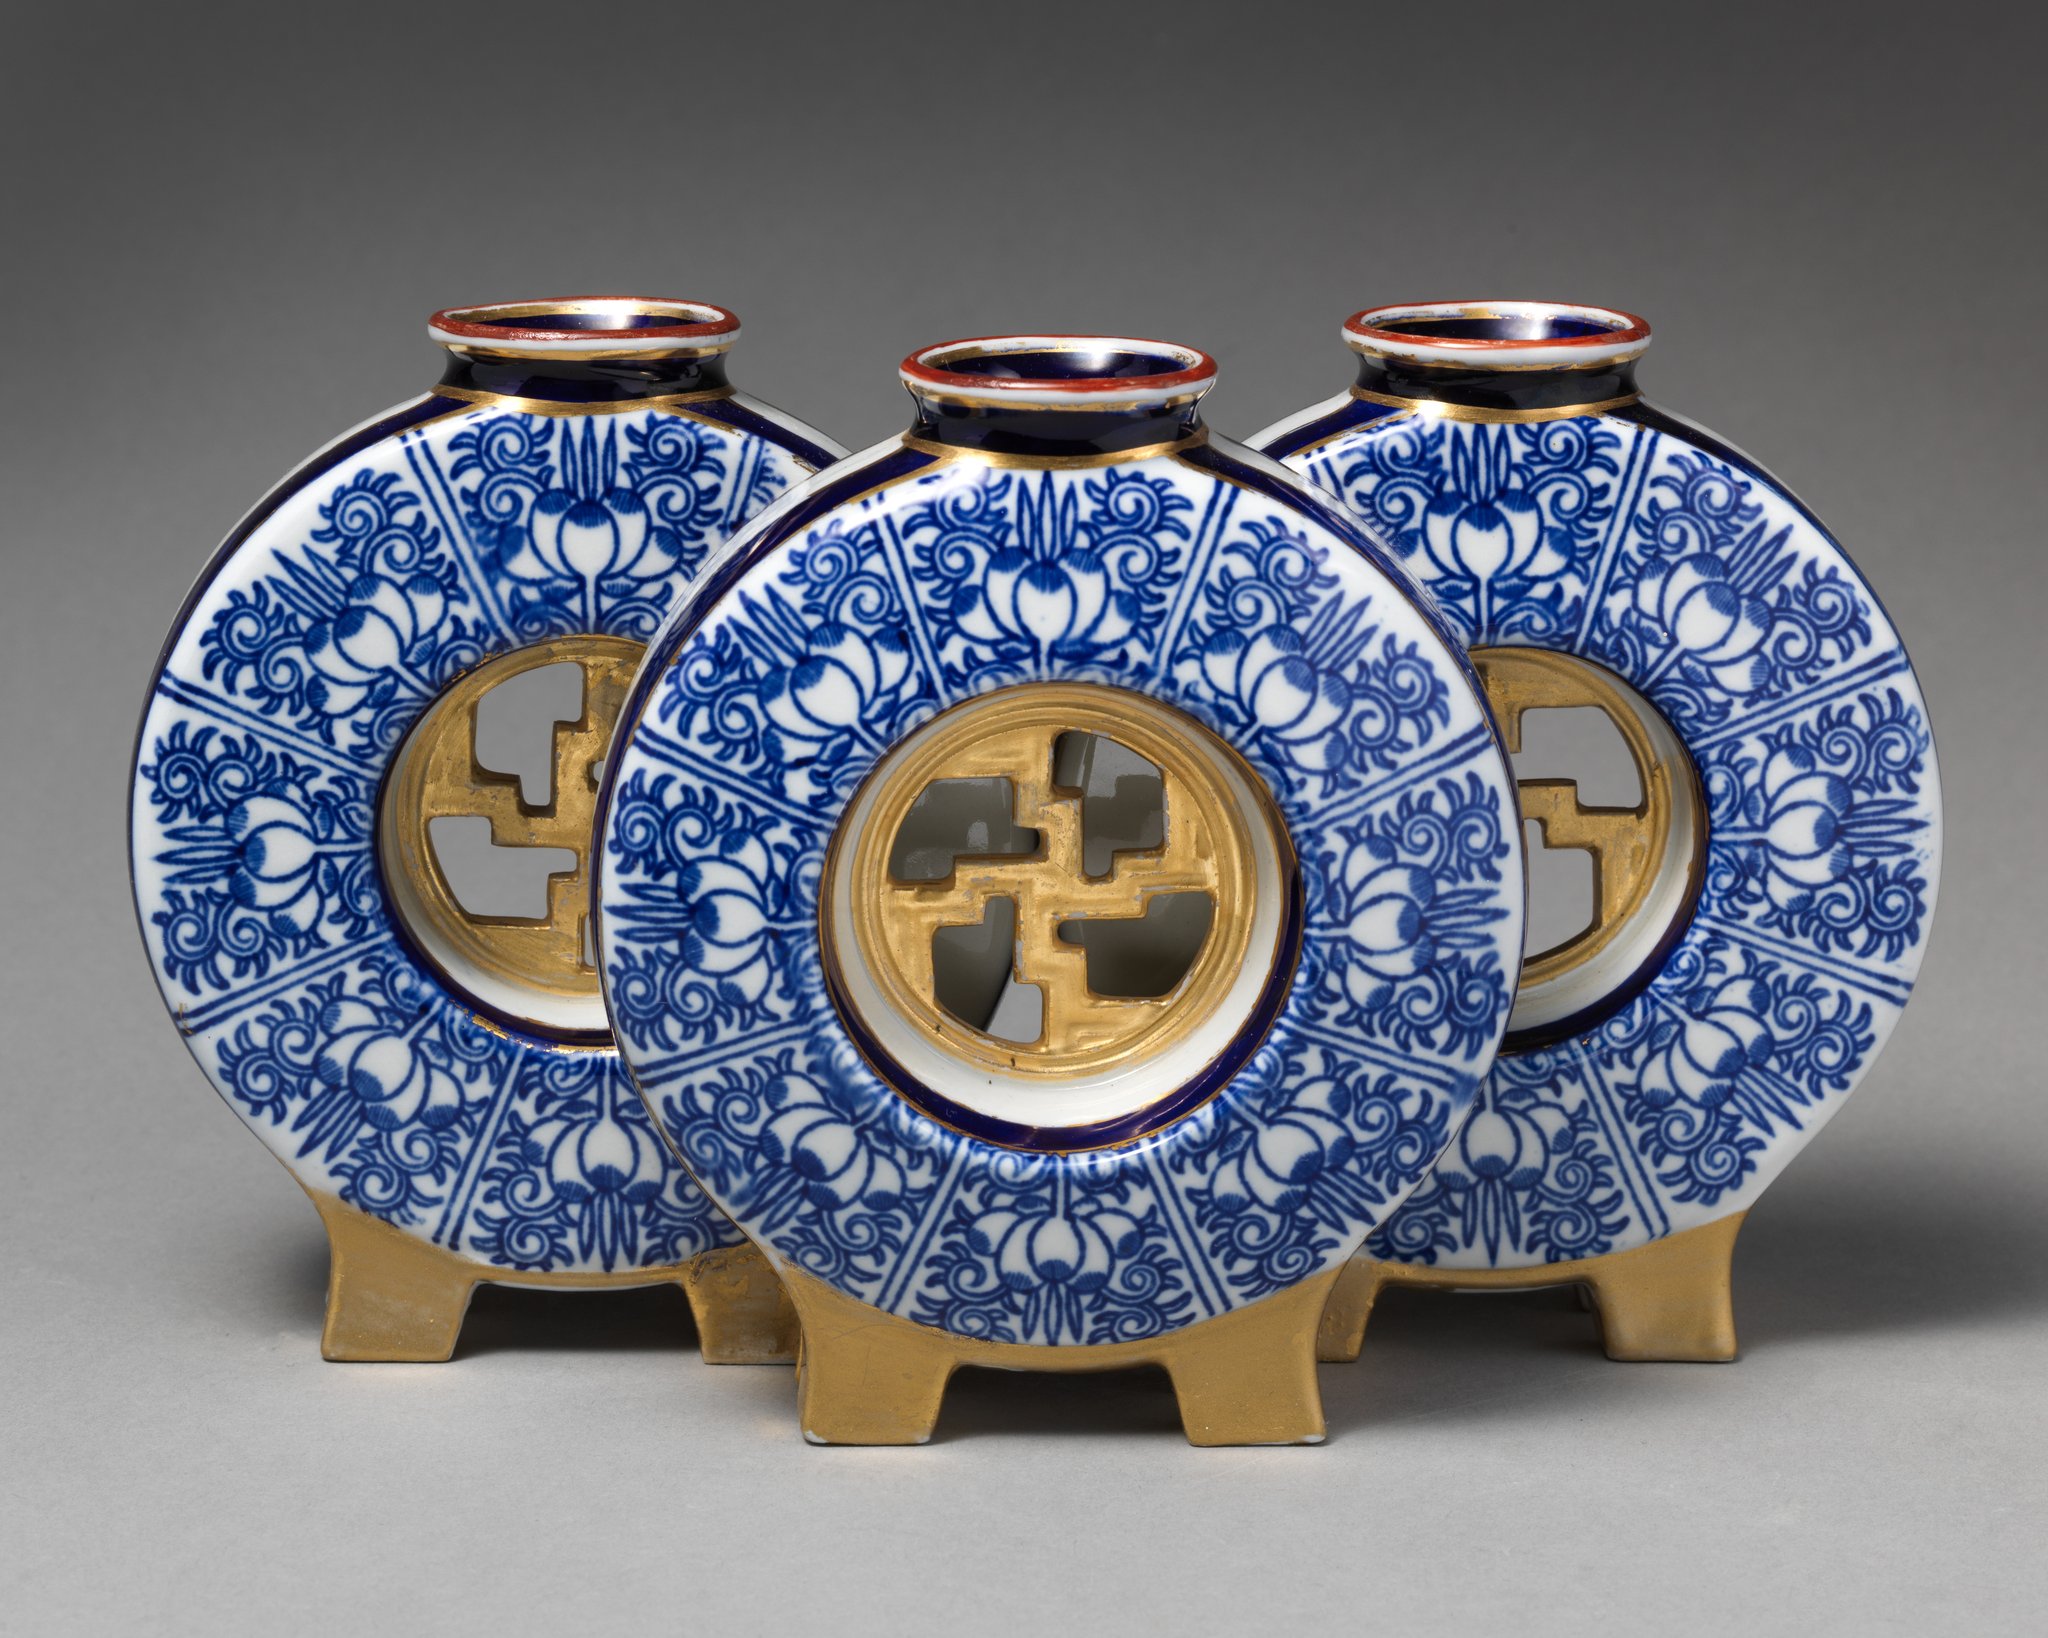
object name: moon flask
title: Triple moon flask with fretwork center (one of a pair)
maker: worcester factory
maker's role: maker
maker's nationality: british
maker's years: 1751-2008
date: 1880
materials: bone china